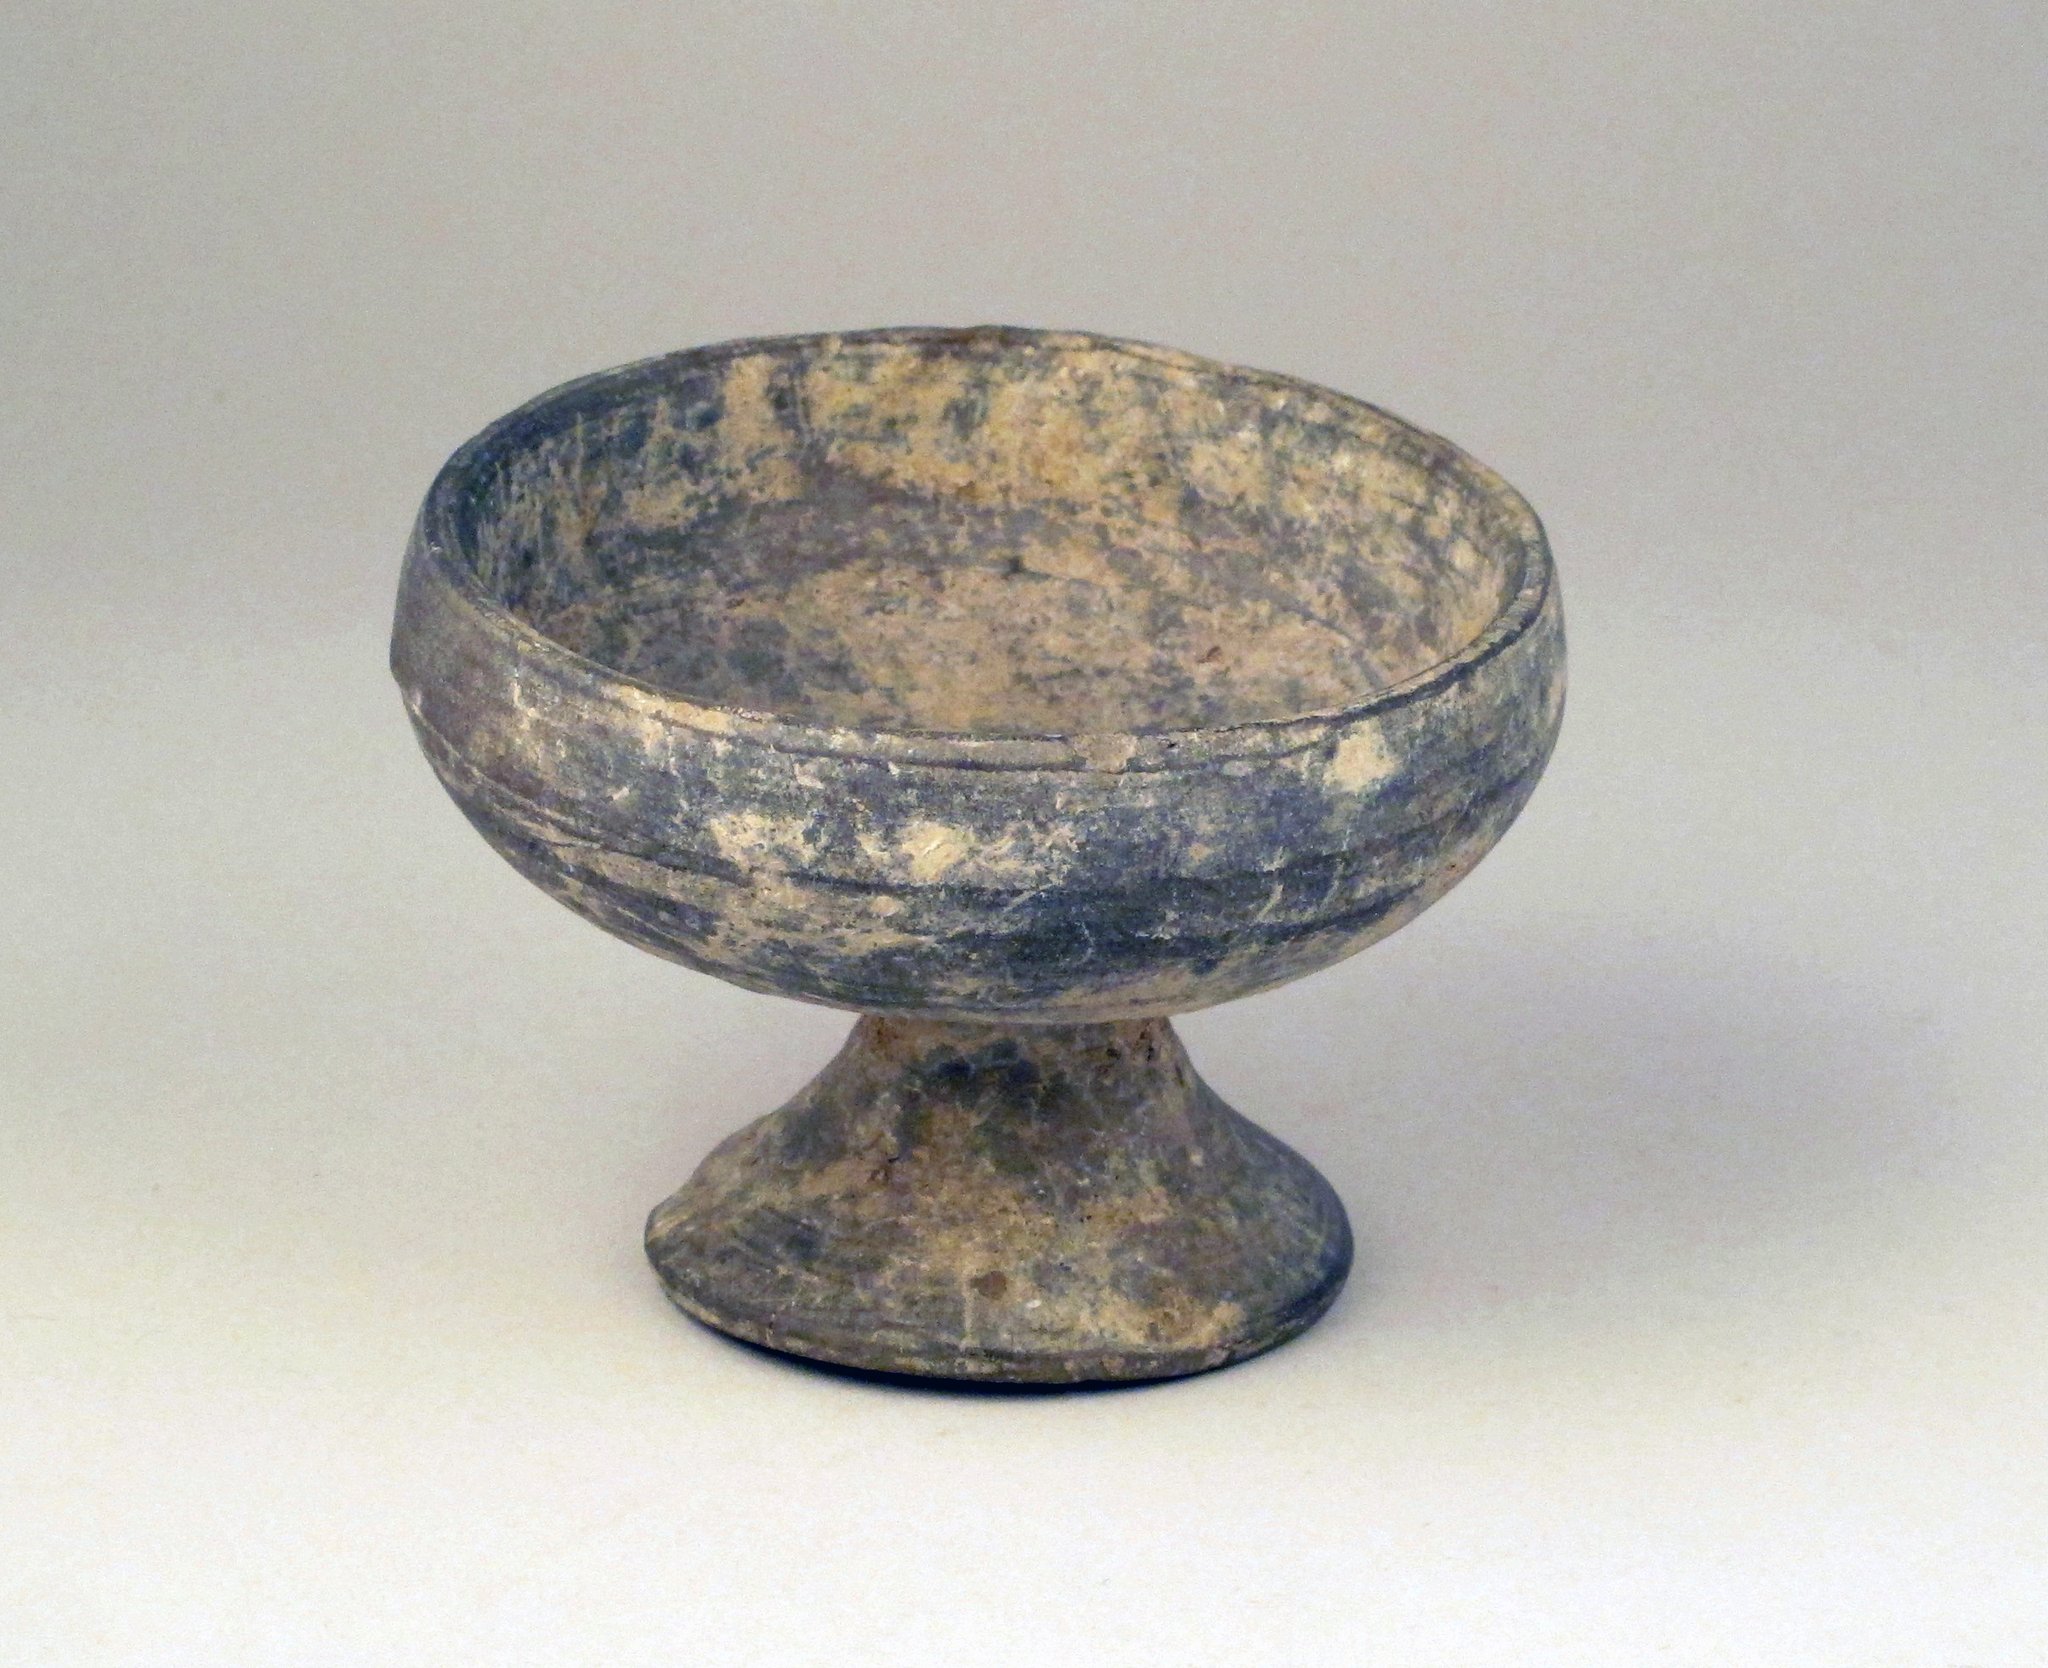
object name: cup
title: Terracotta chalice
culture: etruscan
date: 550-500 BCE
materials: terracotta